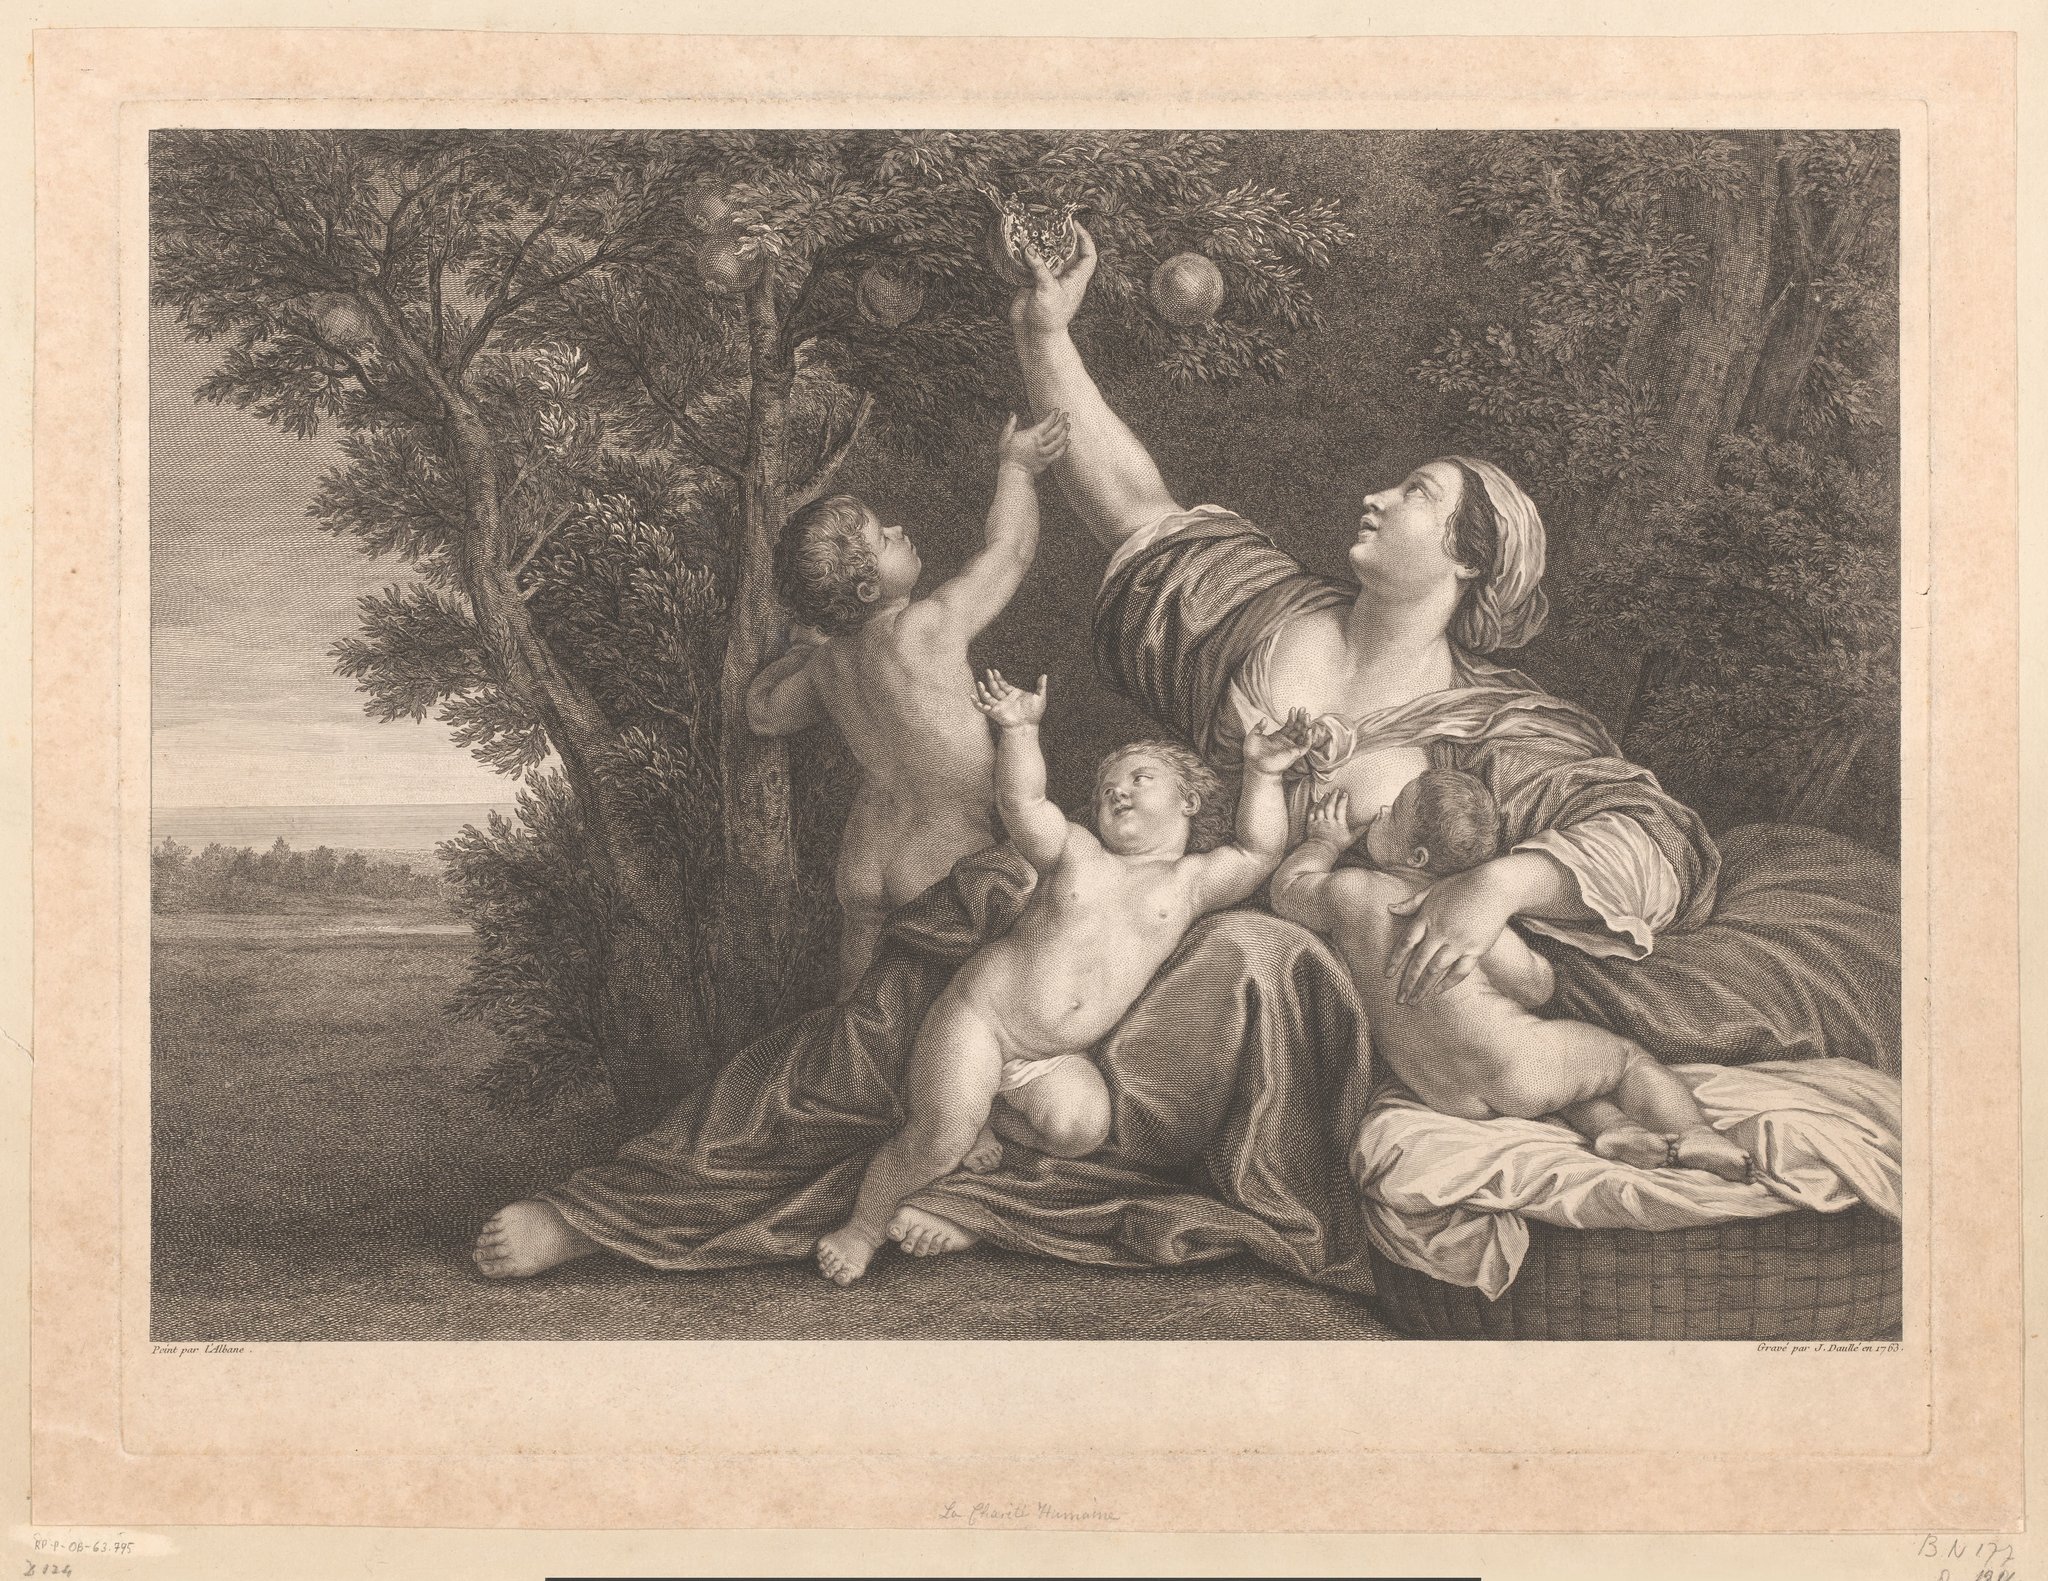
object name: print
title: Moeder met kind aan de borst terwijl ze granaatappels plukt voor haar kinderen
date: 1763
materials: paper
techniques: engraving, etching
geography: france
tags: charity, 'caritas'; 'carità' (ripa) ~ one of the three theological virtues, fruits: pomegranate, feeding a baby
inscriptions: collector's mark: Lugt 240